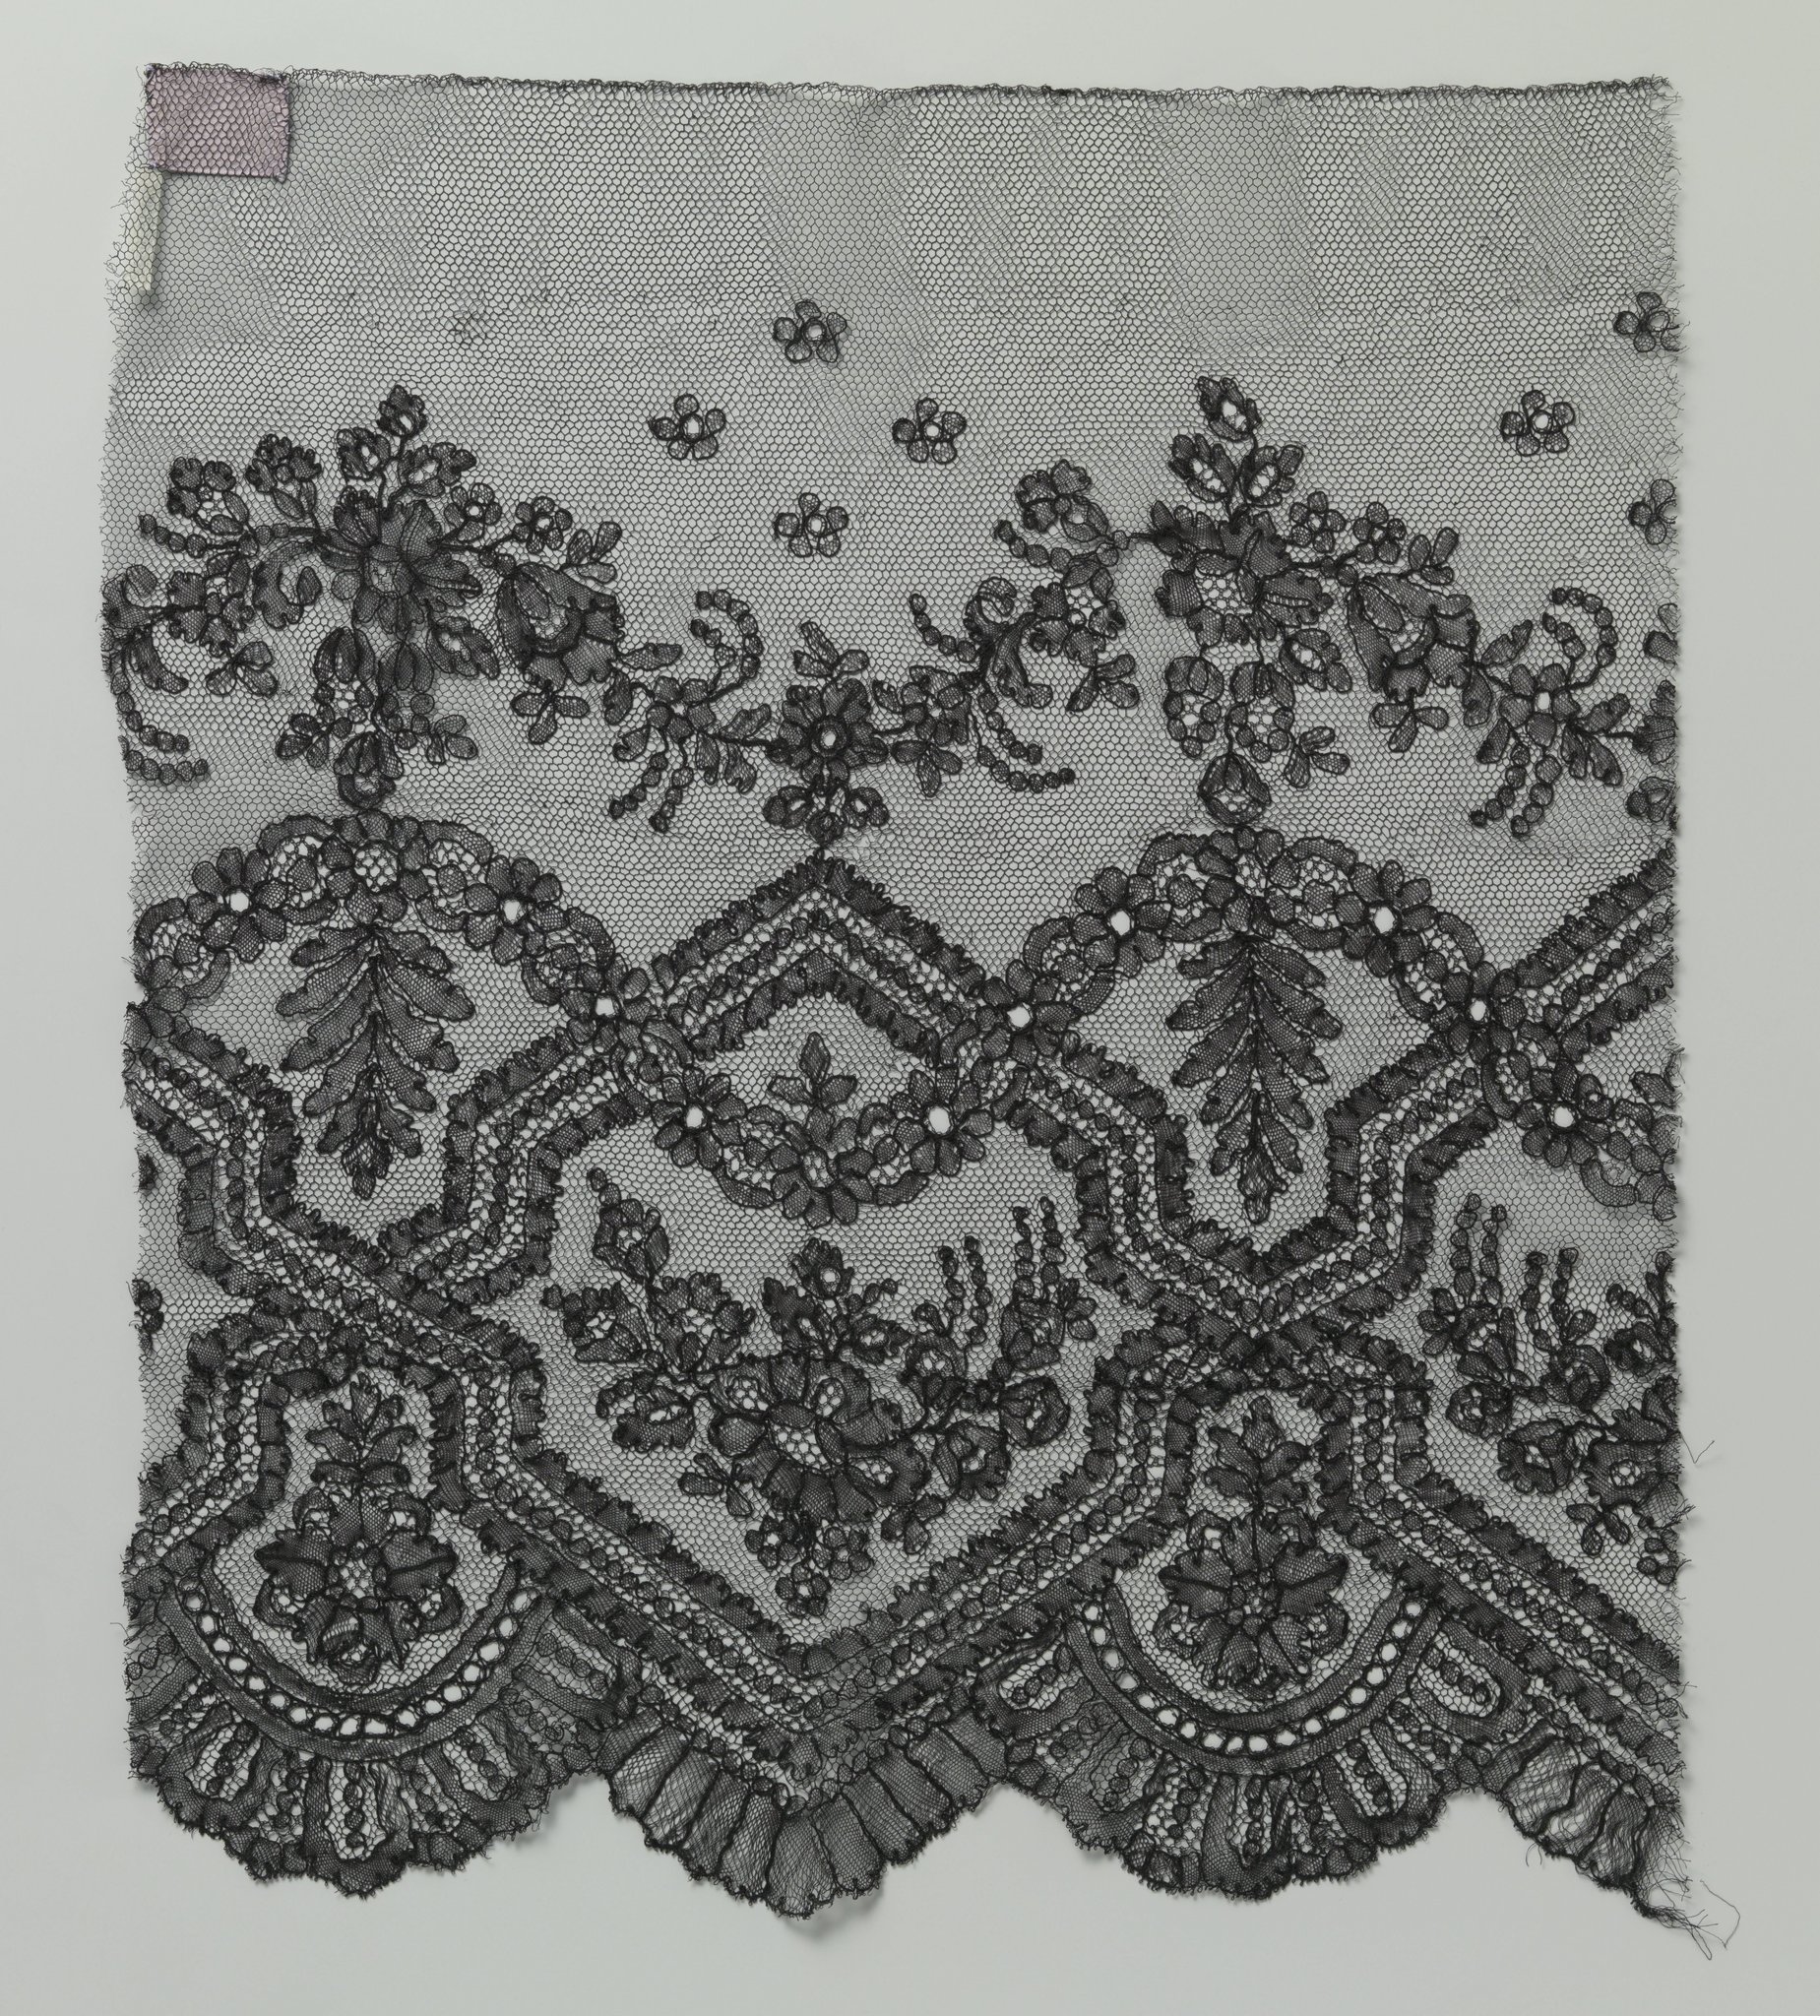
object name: strip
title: Strook kloskant met rozentak in zeshoek en twee golvende bloemslingers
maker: Anonymous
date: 1860-1875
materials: silk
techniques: lace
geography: belgium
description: Strook zwarte kloskant: Chantilly-kant. De strook is een deel van een langere strook, die is gebruikt voor een crinoline japon. Het zich herhalende patroon bestaat uit zeshoekige velden, die gevormd worden door elkaar kruisende sierbanden. In elk zeshoekig veld ligt een rozentak. Boven de zeshoeken lopen twee synchroon golvende bloemslingers, waarvan de onderste slinger de bovenste punten van de zeshoeken oversnijdt. Tussen de zeshoeken, de onderste bloemslinger en de schulpenrand in ontstaan klokvormige velden, met in het onderste steeds één grote roos en in het gespiegelde klokvormige veld daarboven staat een veervormig blad. De motieven zijn gemaakt in netslag met contourdraden en ze zijn met elkaar verbonden door een fijne traliegrond, een tulegrond. Als siergrond is een rozengrond toegepast in onder andere bloemharten en sierbanden. De bovenzijde van de strook is recht afgewerkt. De schulpenrand langs de onderzijde van de strook is afgewerkt met picots.